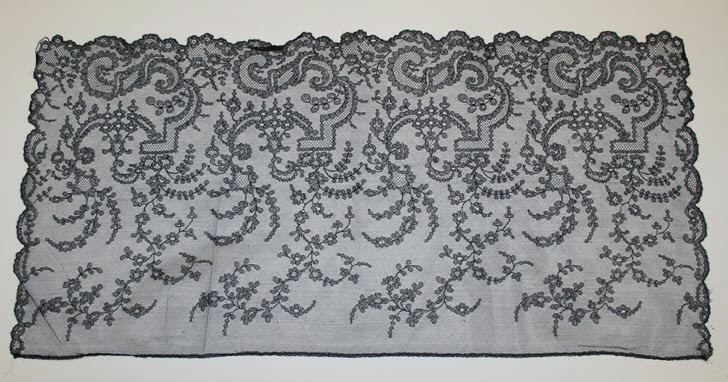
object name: veil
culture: american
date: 1840-1859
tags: flowers